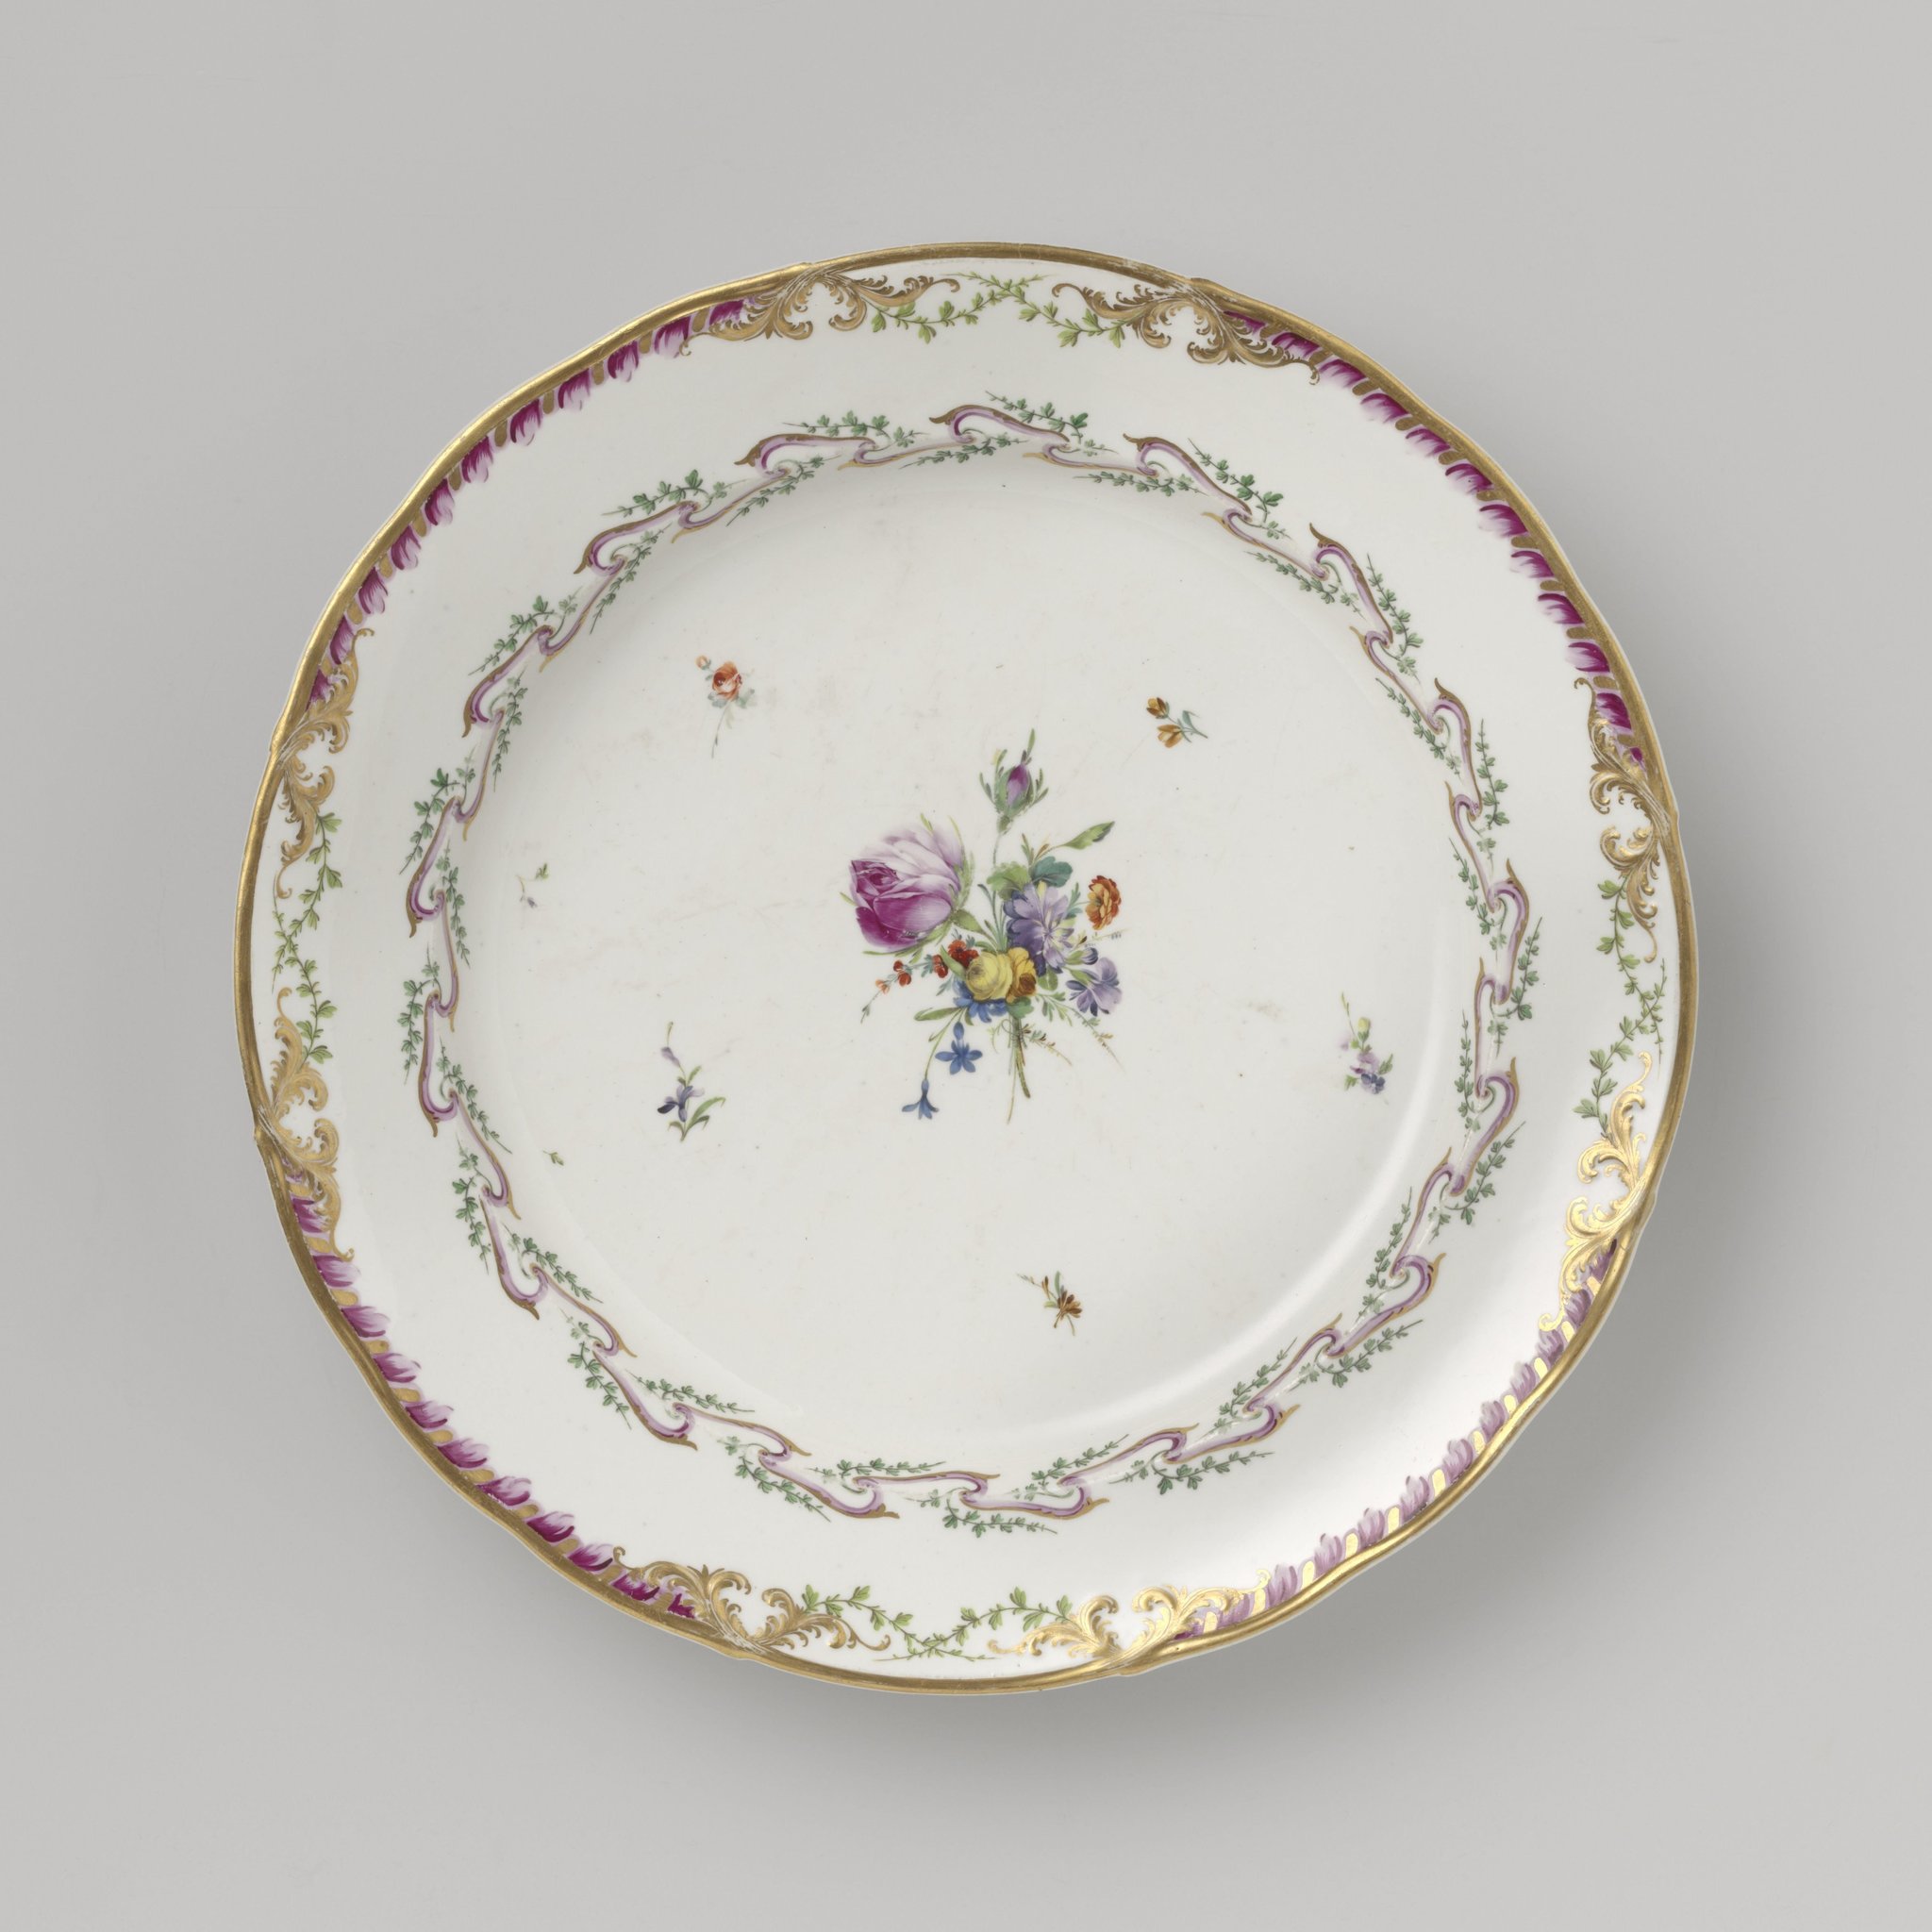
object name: platter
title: Schotel, behorend bij een servies versierd met lintmotief met bladeren, bloemboeketten en gestrooide bloemtakken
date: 1780-1820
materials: porcelain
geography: amsterdam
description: Schotel van porselein, behorend bij een servies van porselein versierd met een geslingerd lintmotief in paars en goud met groene bladertakken, bloemboeketten en gestrooide bloemtakken. Randen licht gegolfd, met decoratie in goud met paars bladmotief waartussen groen gekruist bladmotief. Gemerkt: M.O.L. en Amstel.